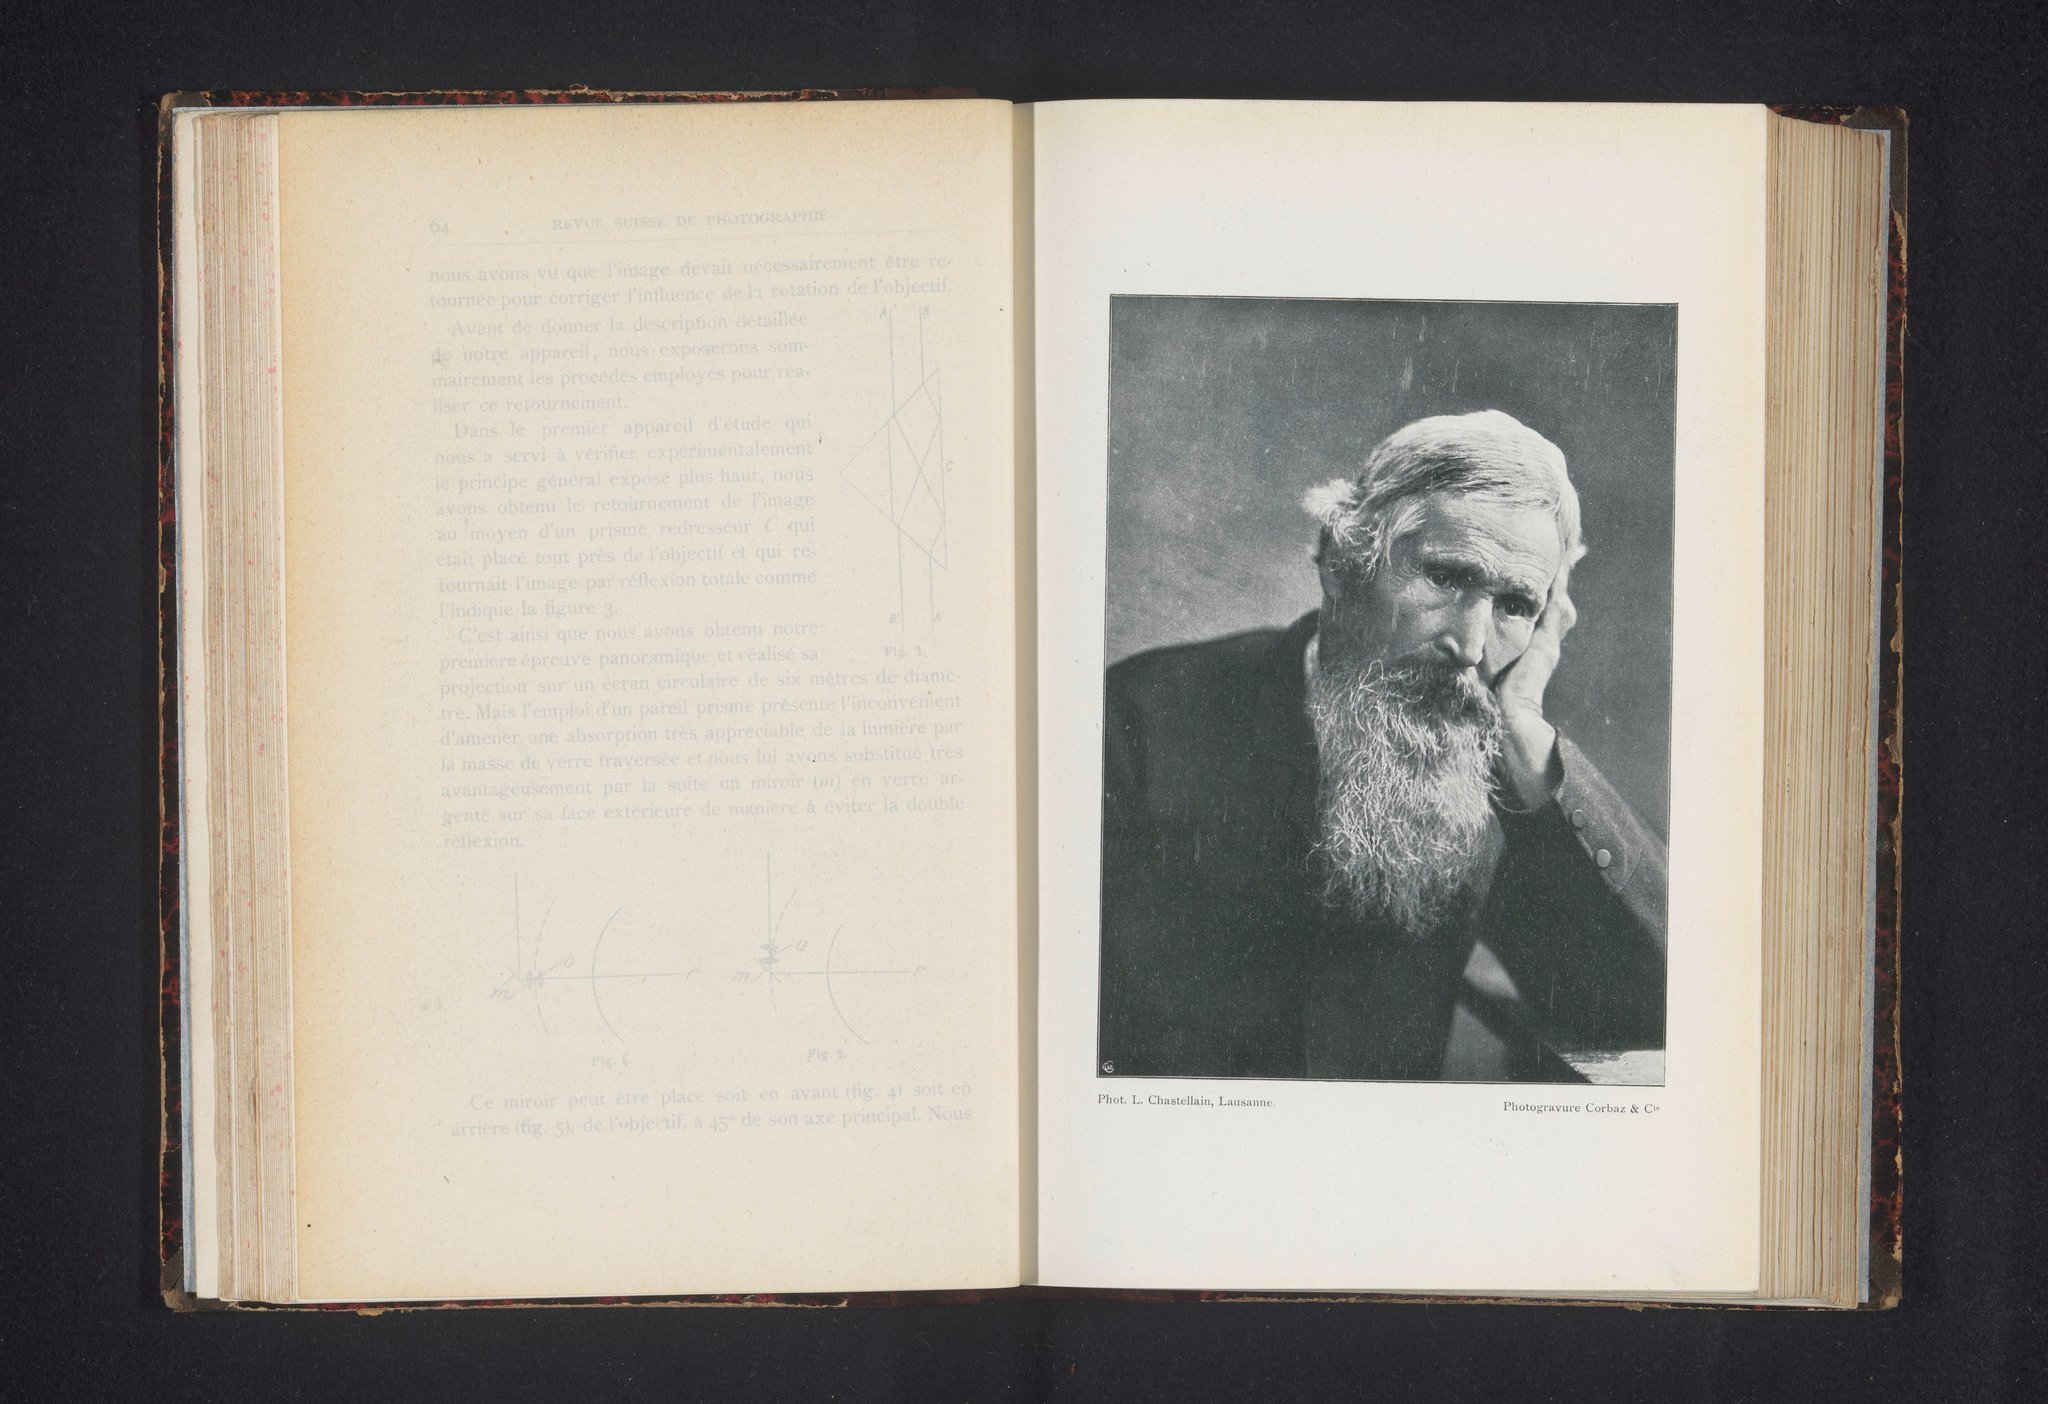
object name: page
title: Portret van een onbekende man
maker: l. chastellain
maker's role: fotograaf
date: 1897-1902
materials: paper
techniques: autotype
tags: historical persons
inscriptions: monogram: ‘C. Cie’